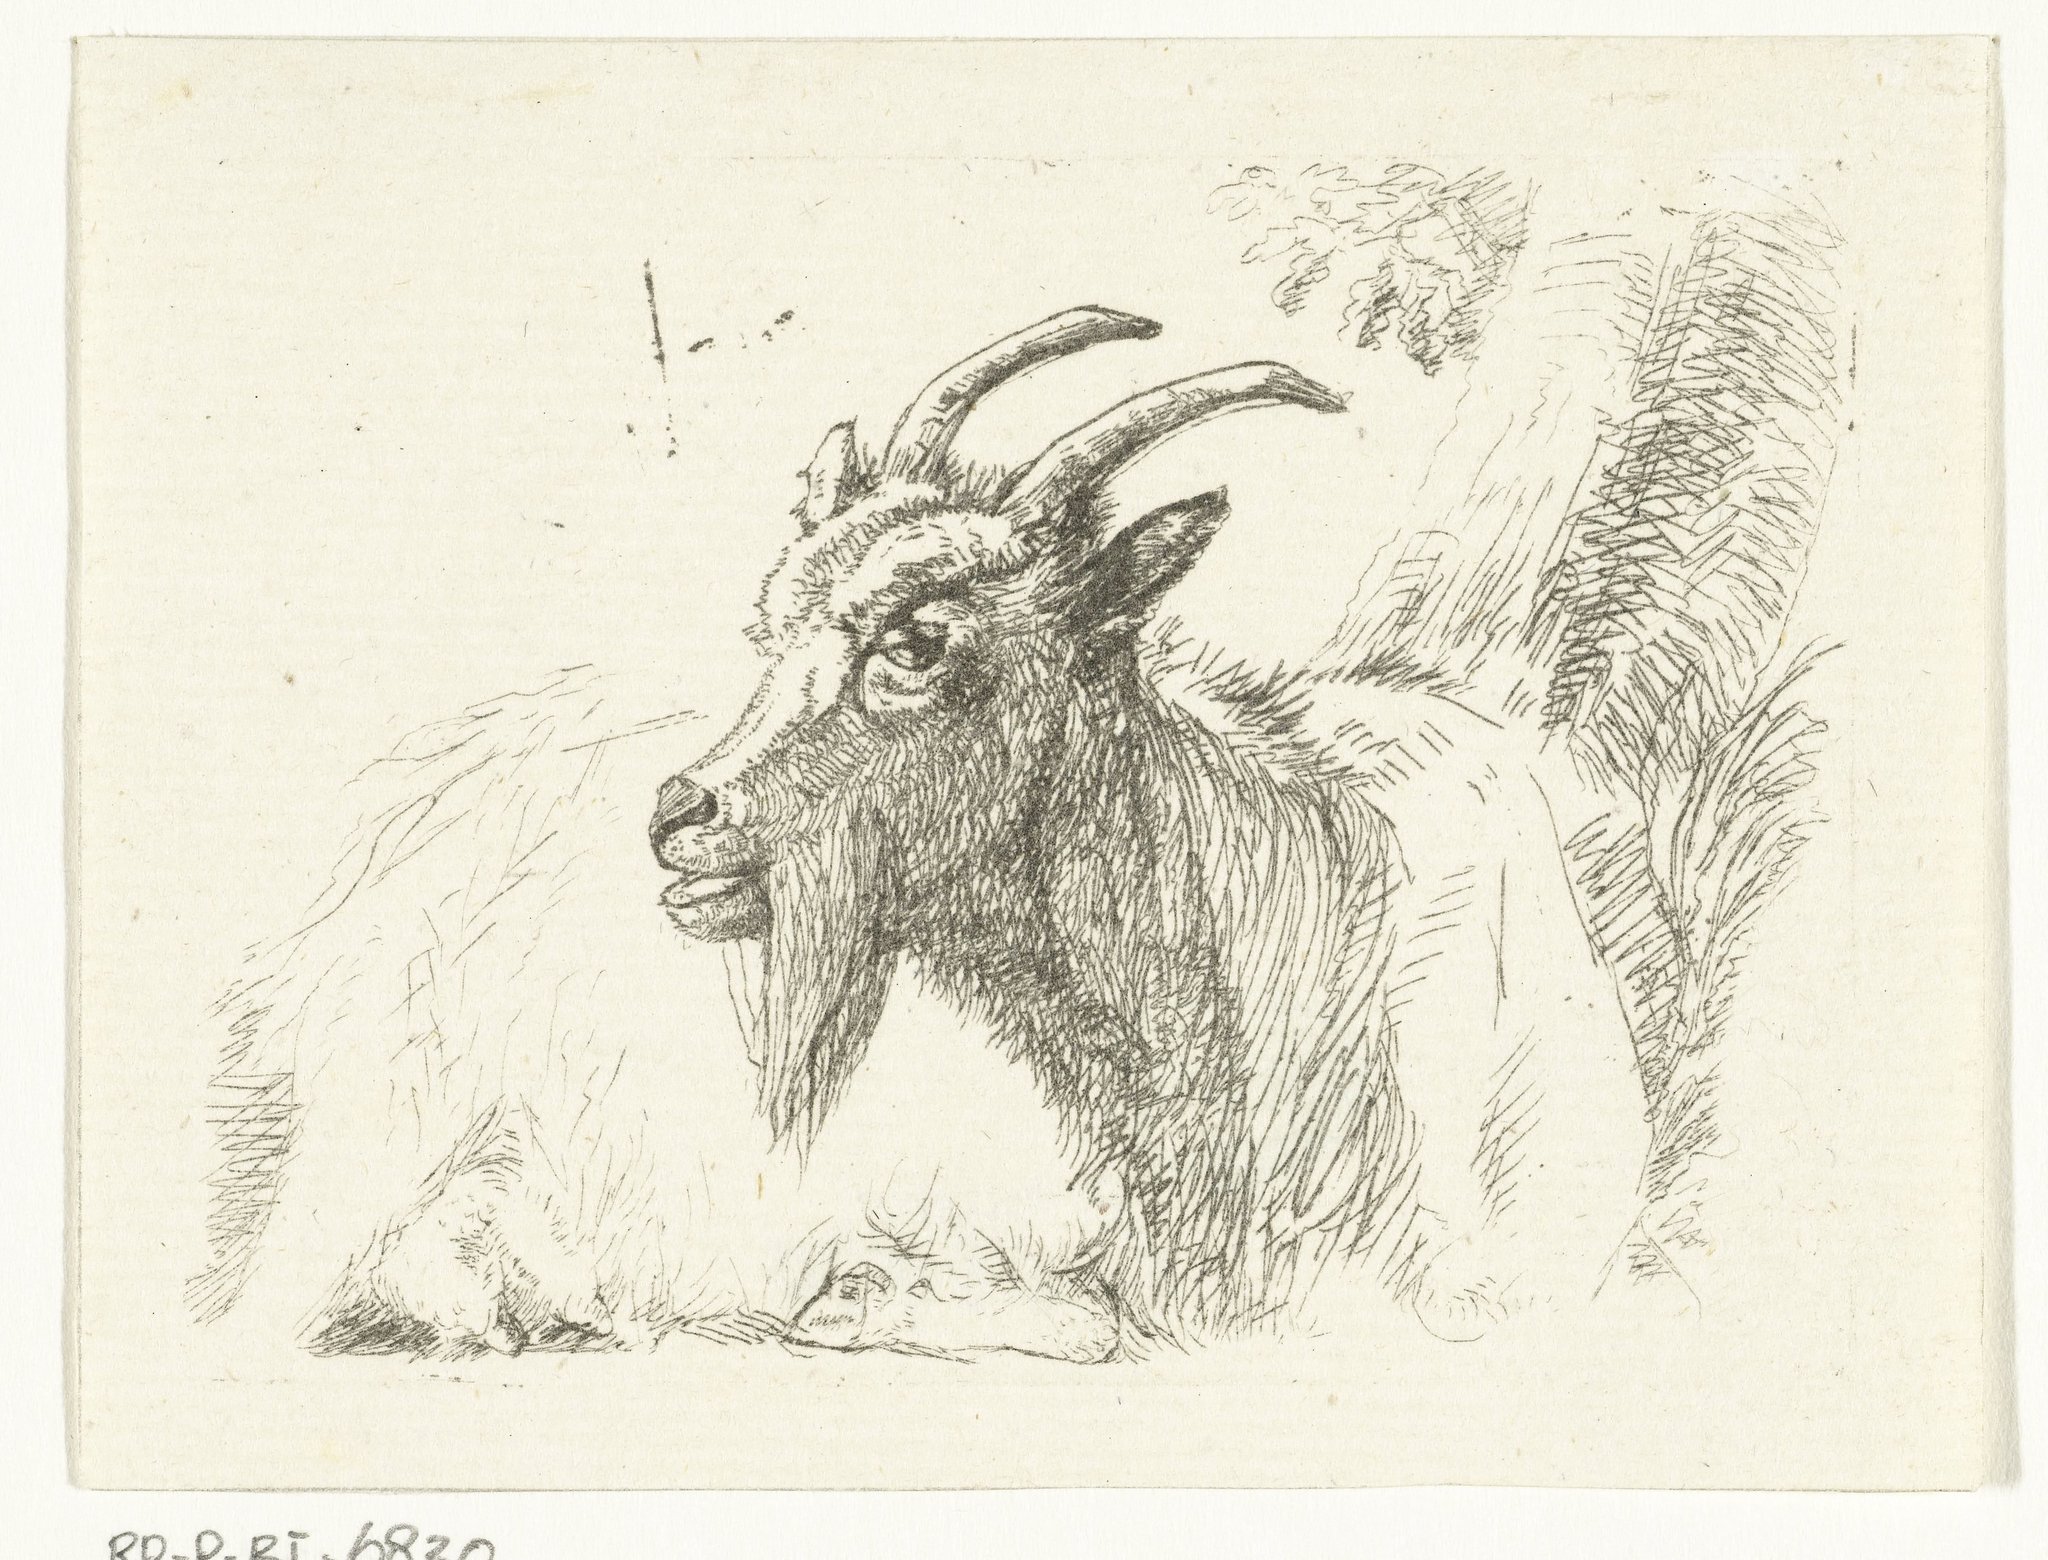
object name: print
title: Liggende geit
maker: jan dasveldt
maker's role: draughtsman, print maker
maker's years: 1770-1855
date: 1780-1855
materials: paper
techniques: etching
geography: amsterdam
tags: goat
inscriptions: collector's mark: Lugt 2228, collector's mark: Lugt 1962